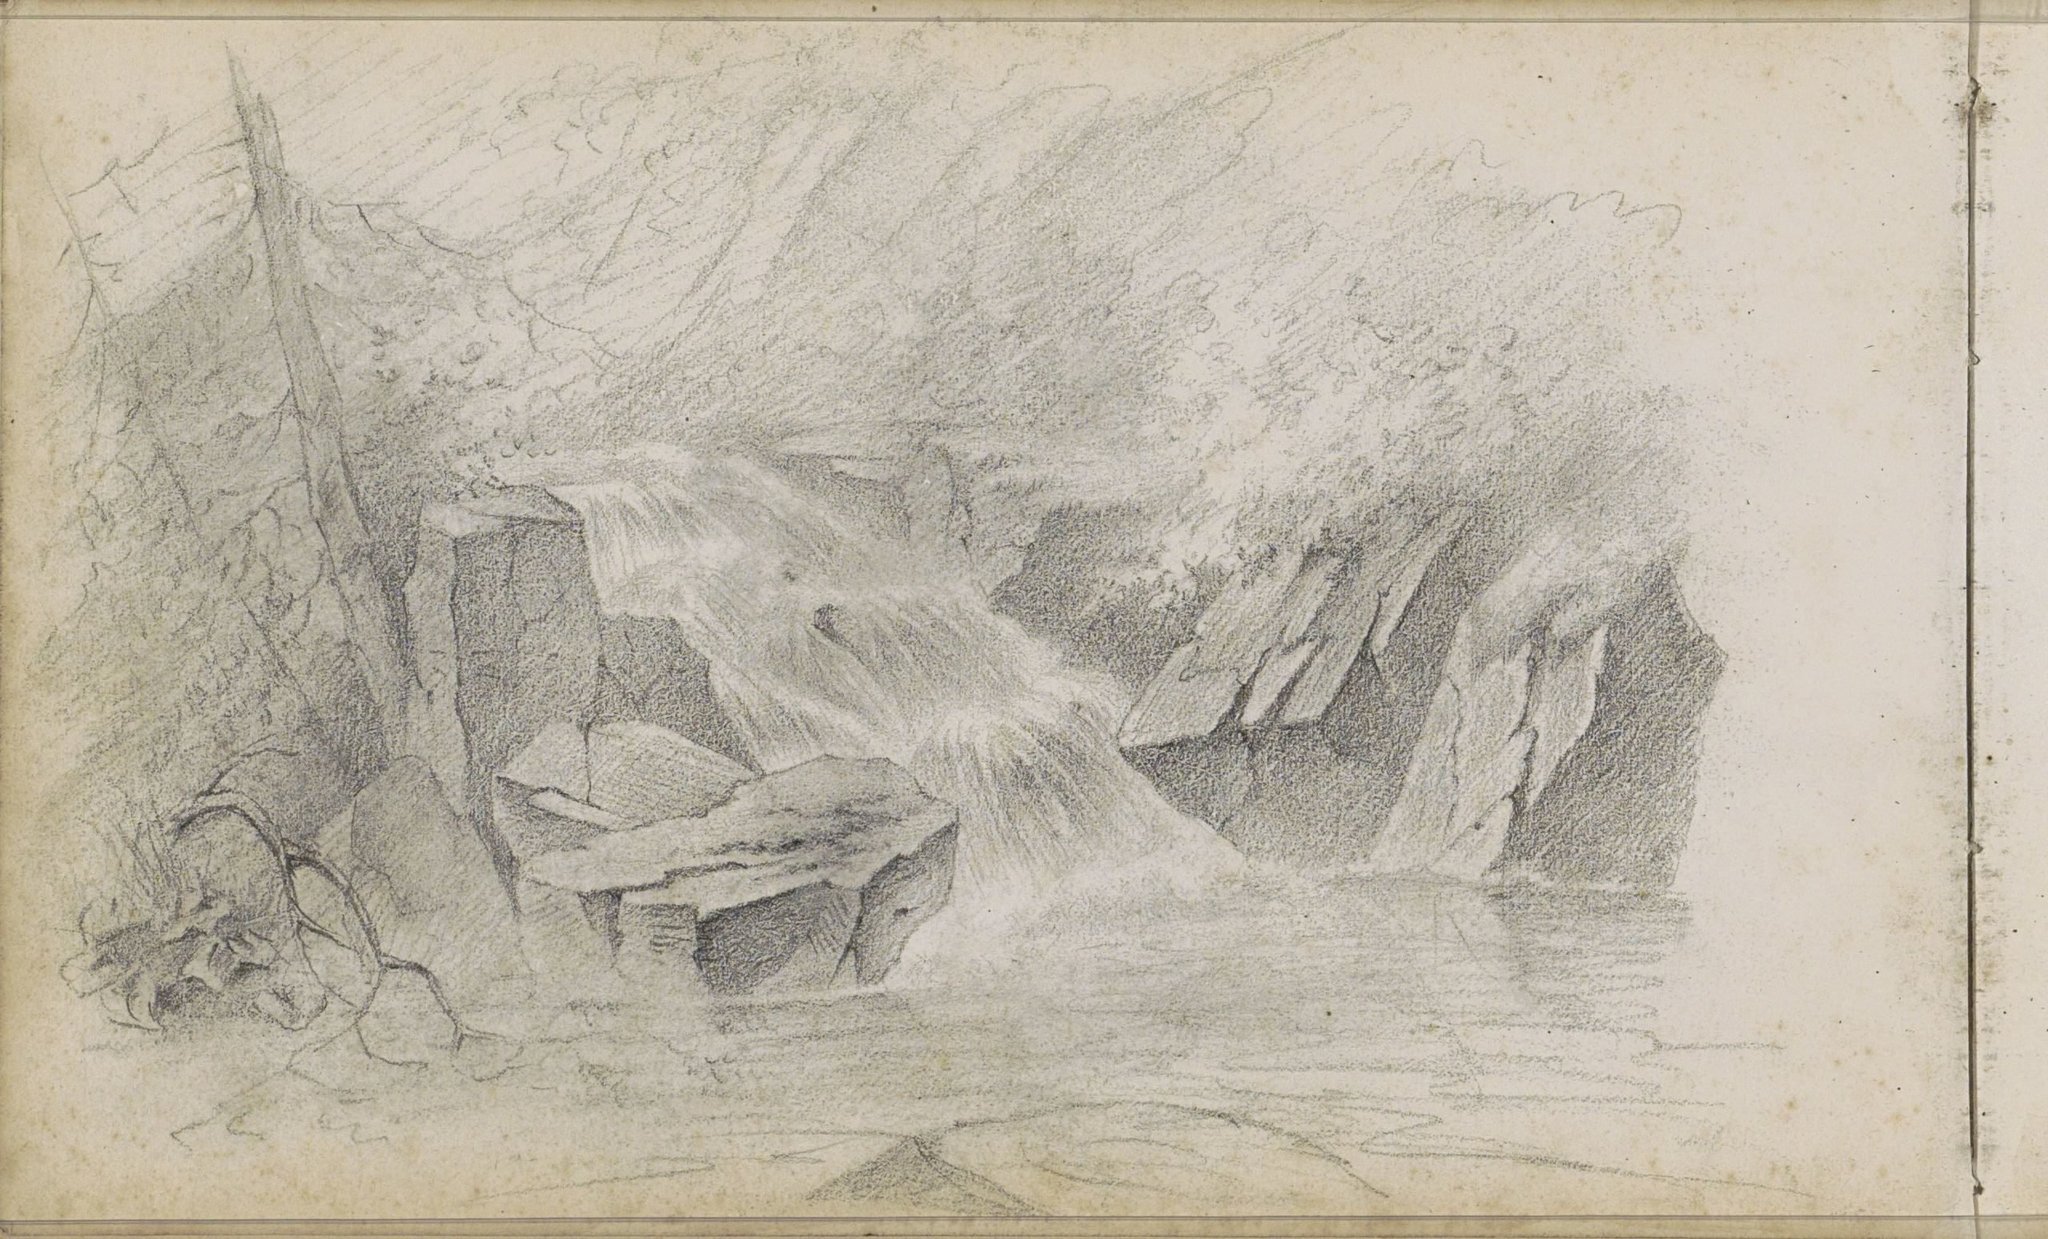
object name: sketchbook leaf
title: Waterval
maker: willem cornelis rip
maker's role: draughtsman, painter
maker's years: 1856-1922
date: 1874-1875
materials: paper, pencil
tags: waterfall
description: Blad 11 verso uit een schetsboek met 46 bladen.